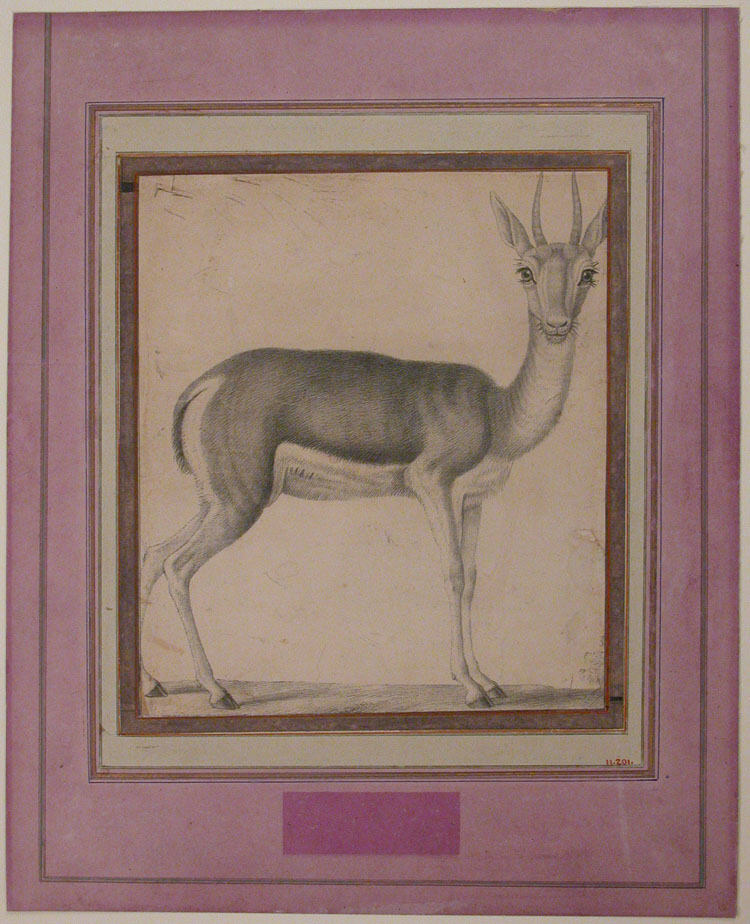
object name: illustrated single work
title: Gazelle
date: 1601-1800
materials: lead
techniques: drawing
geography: india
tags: animals